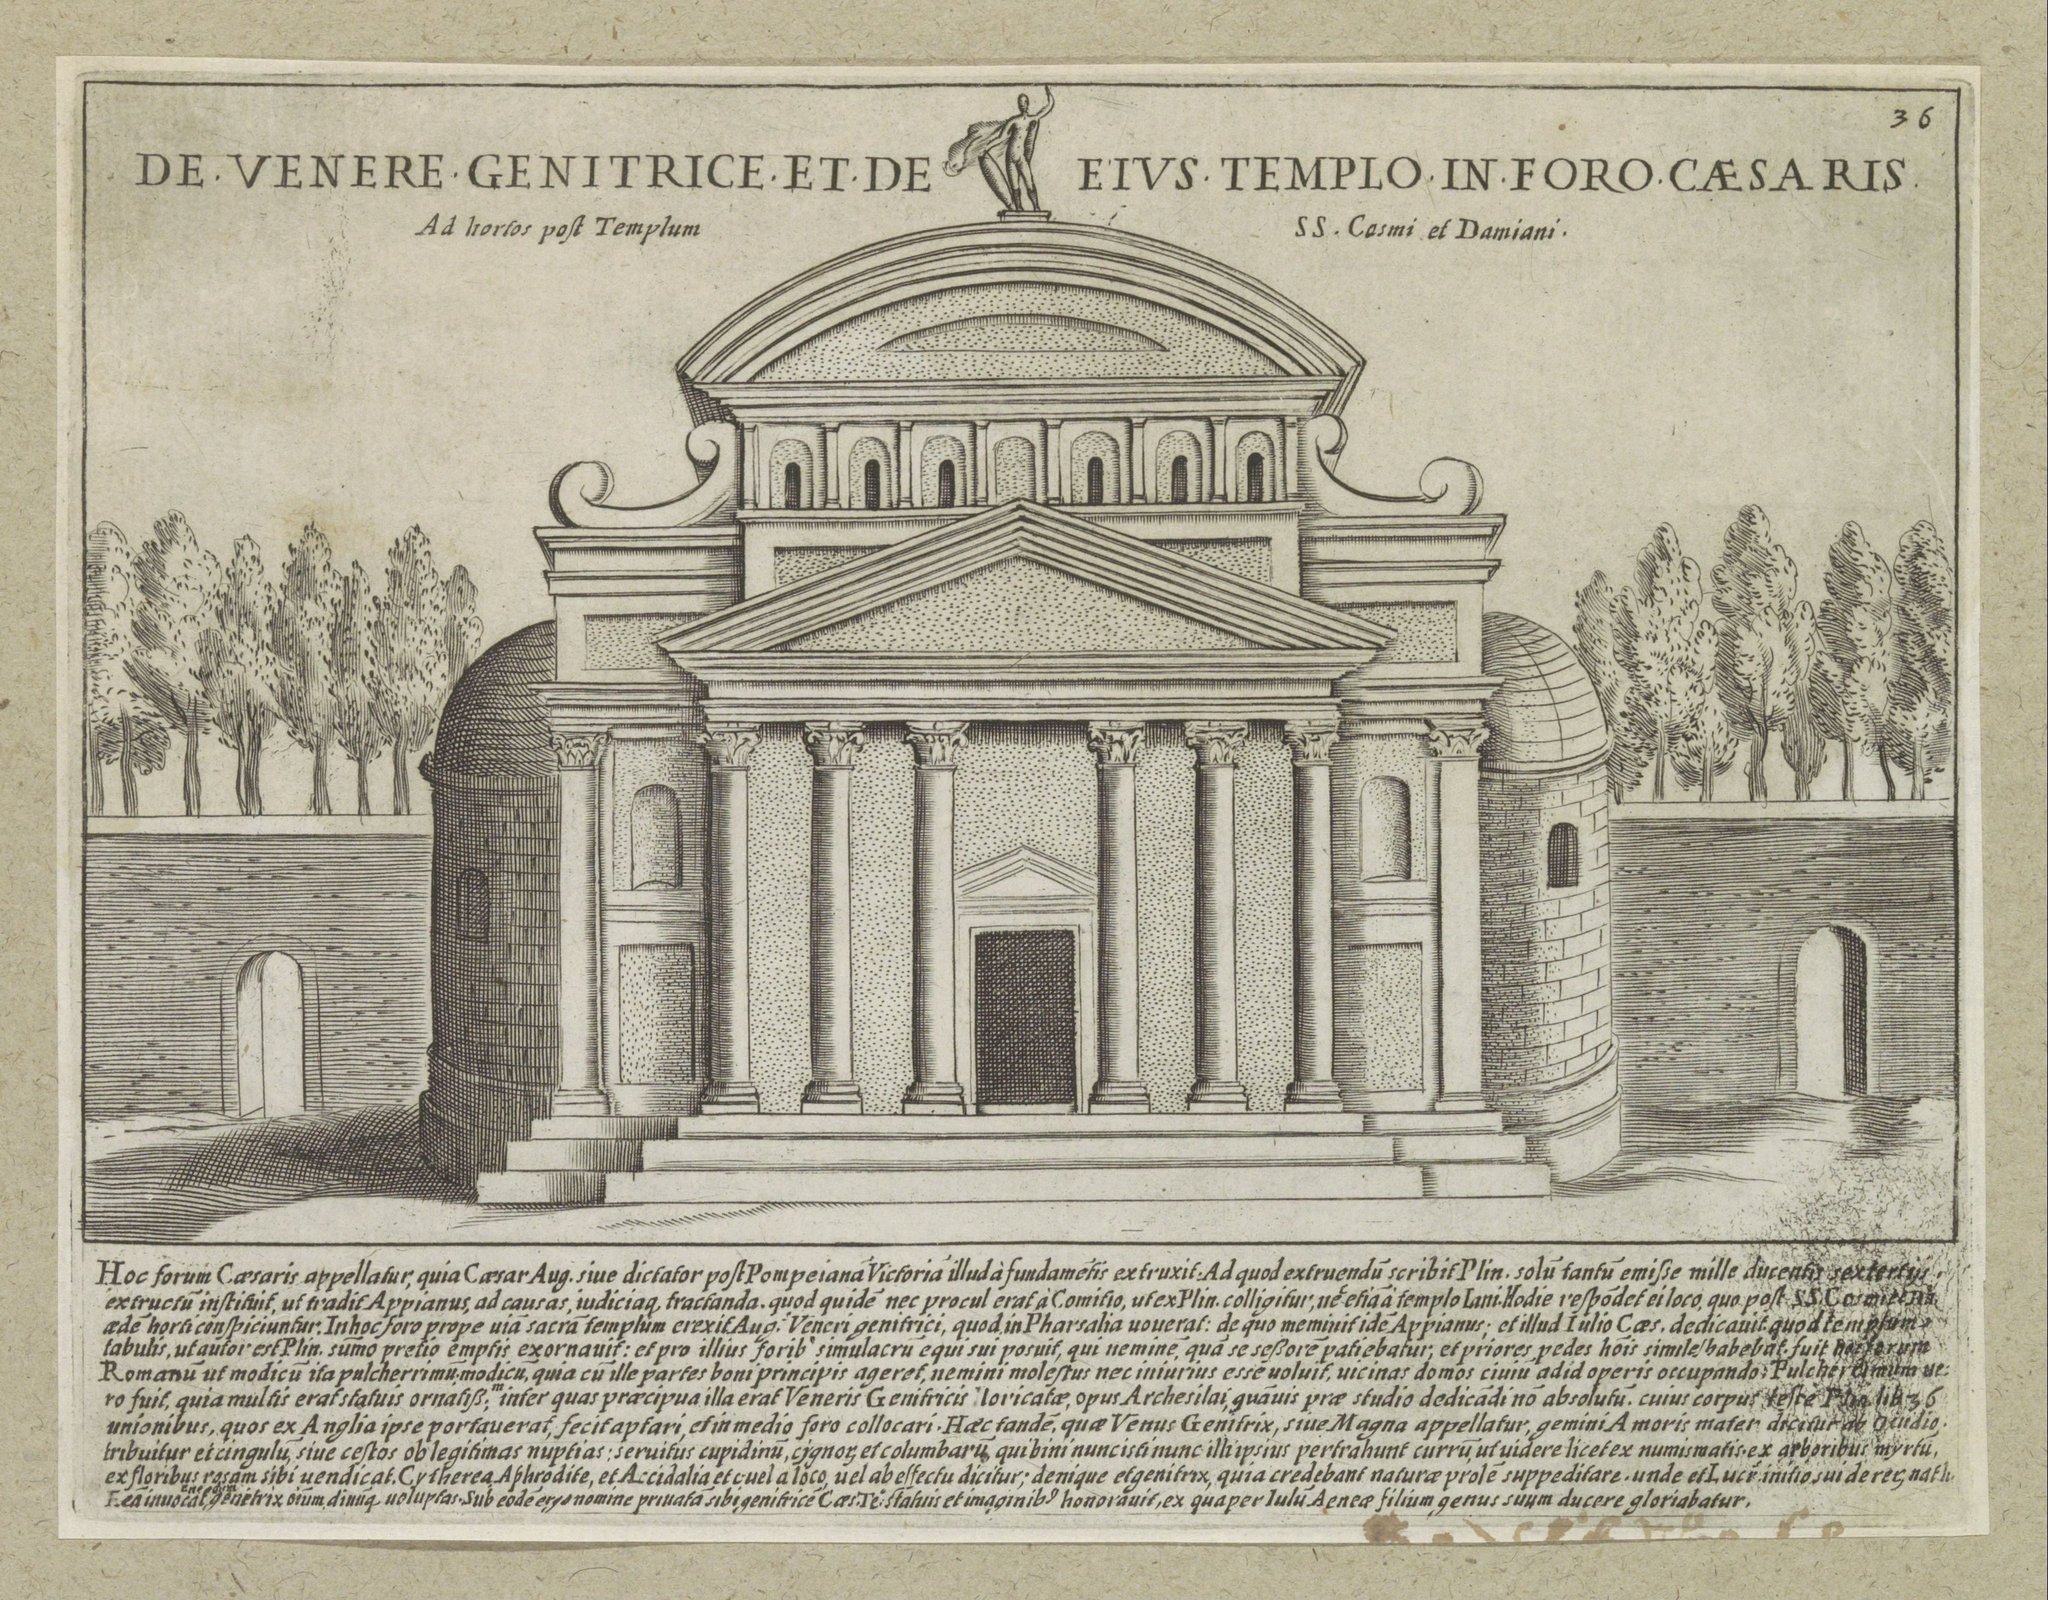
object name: print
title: De Venere Genitrice et de Eius Templo in Foro Caesaris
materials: paper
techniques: etching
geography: italy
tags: temple, shrine ~ roman religion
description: Deze prent maakt deel uit van een set van 158 prenten (+ titelprenten), die verscheen in vier delen. In 1612 verschenen delen één en twee. In 1615 verscheen het derde deel en in 1628 verscheen deel vier. In 1637 publiceerde Vitale Mascardi de eerste heruitgave van de gehele set met nummering.